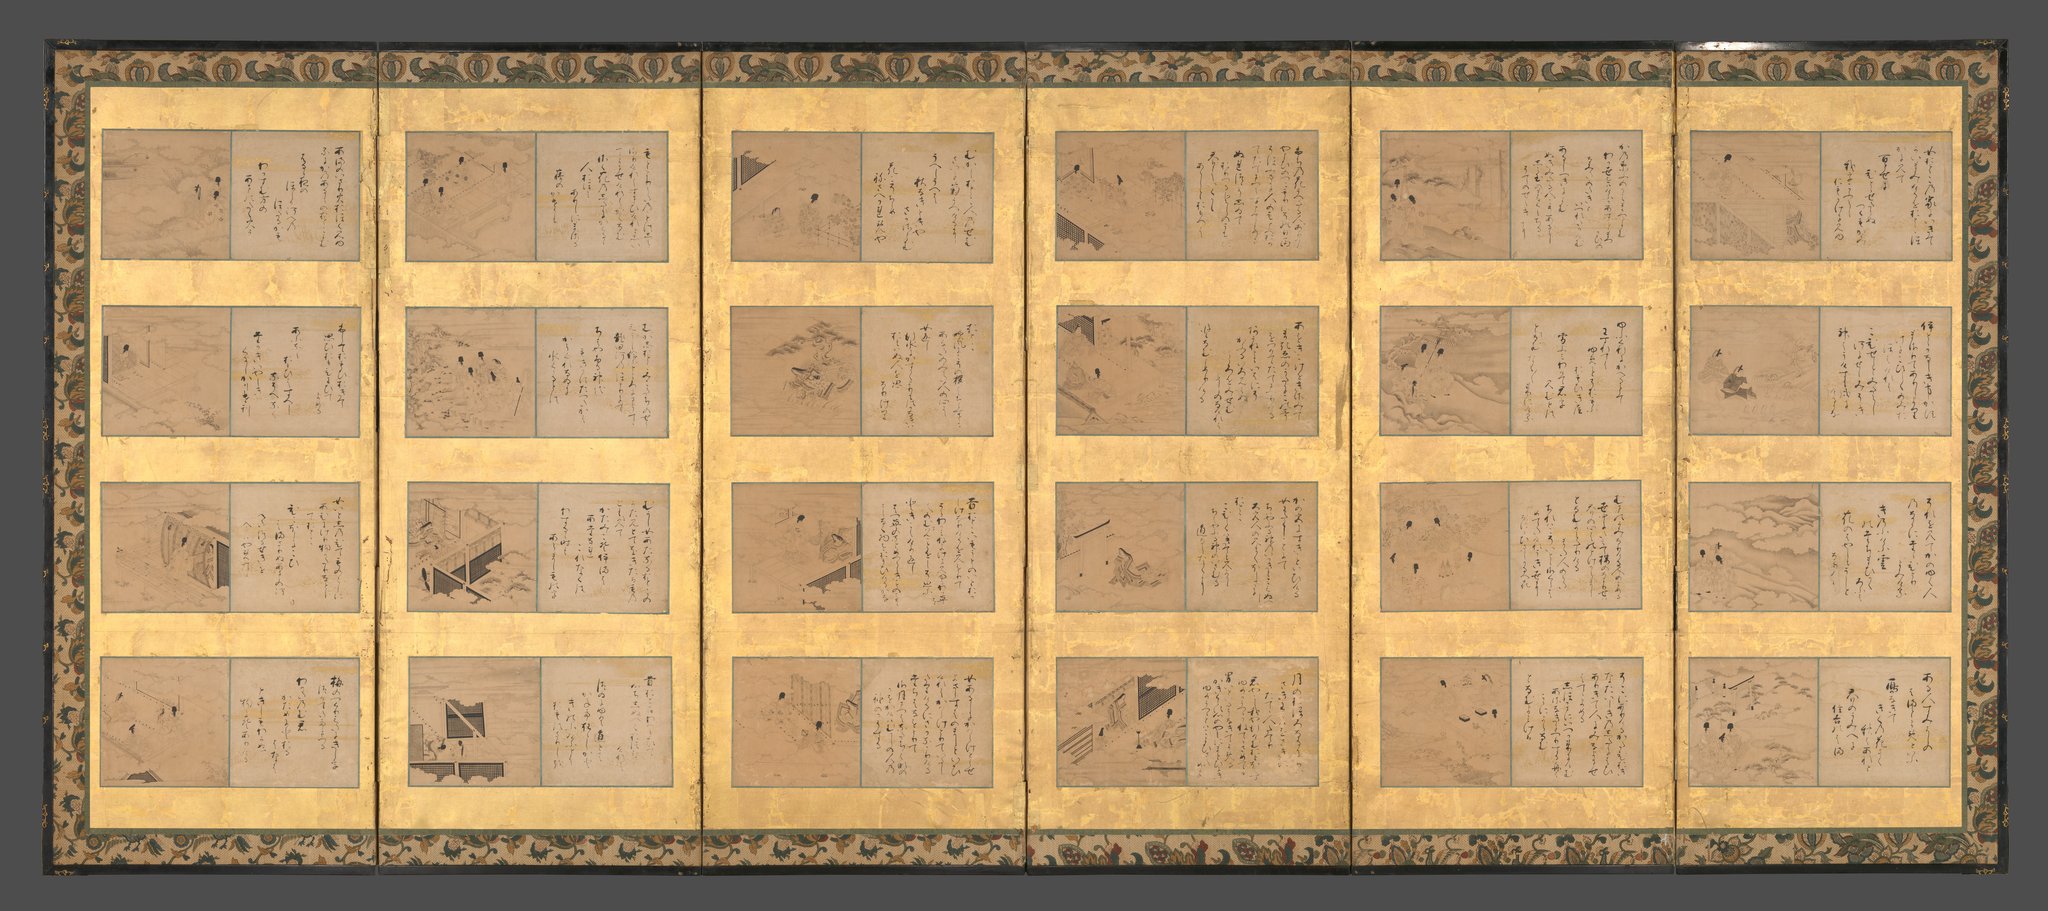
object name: screen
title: Forty-nine scenes from the Tales of Ise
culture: japanese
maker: satomura genchin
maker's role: calligrapher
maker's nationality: japanese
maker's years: 1591-1665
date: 1634-1666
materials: gold leaf, ink, panel, paper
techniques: painting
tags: men,women